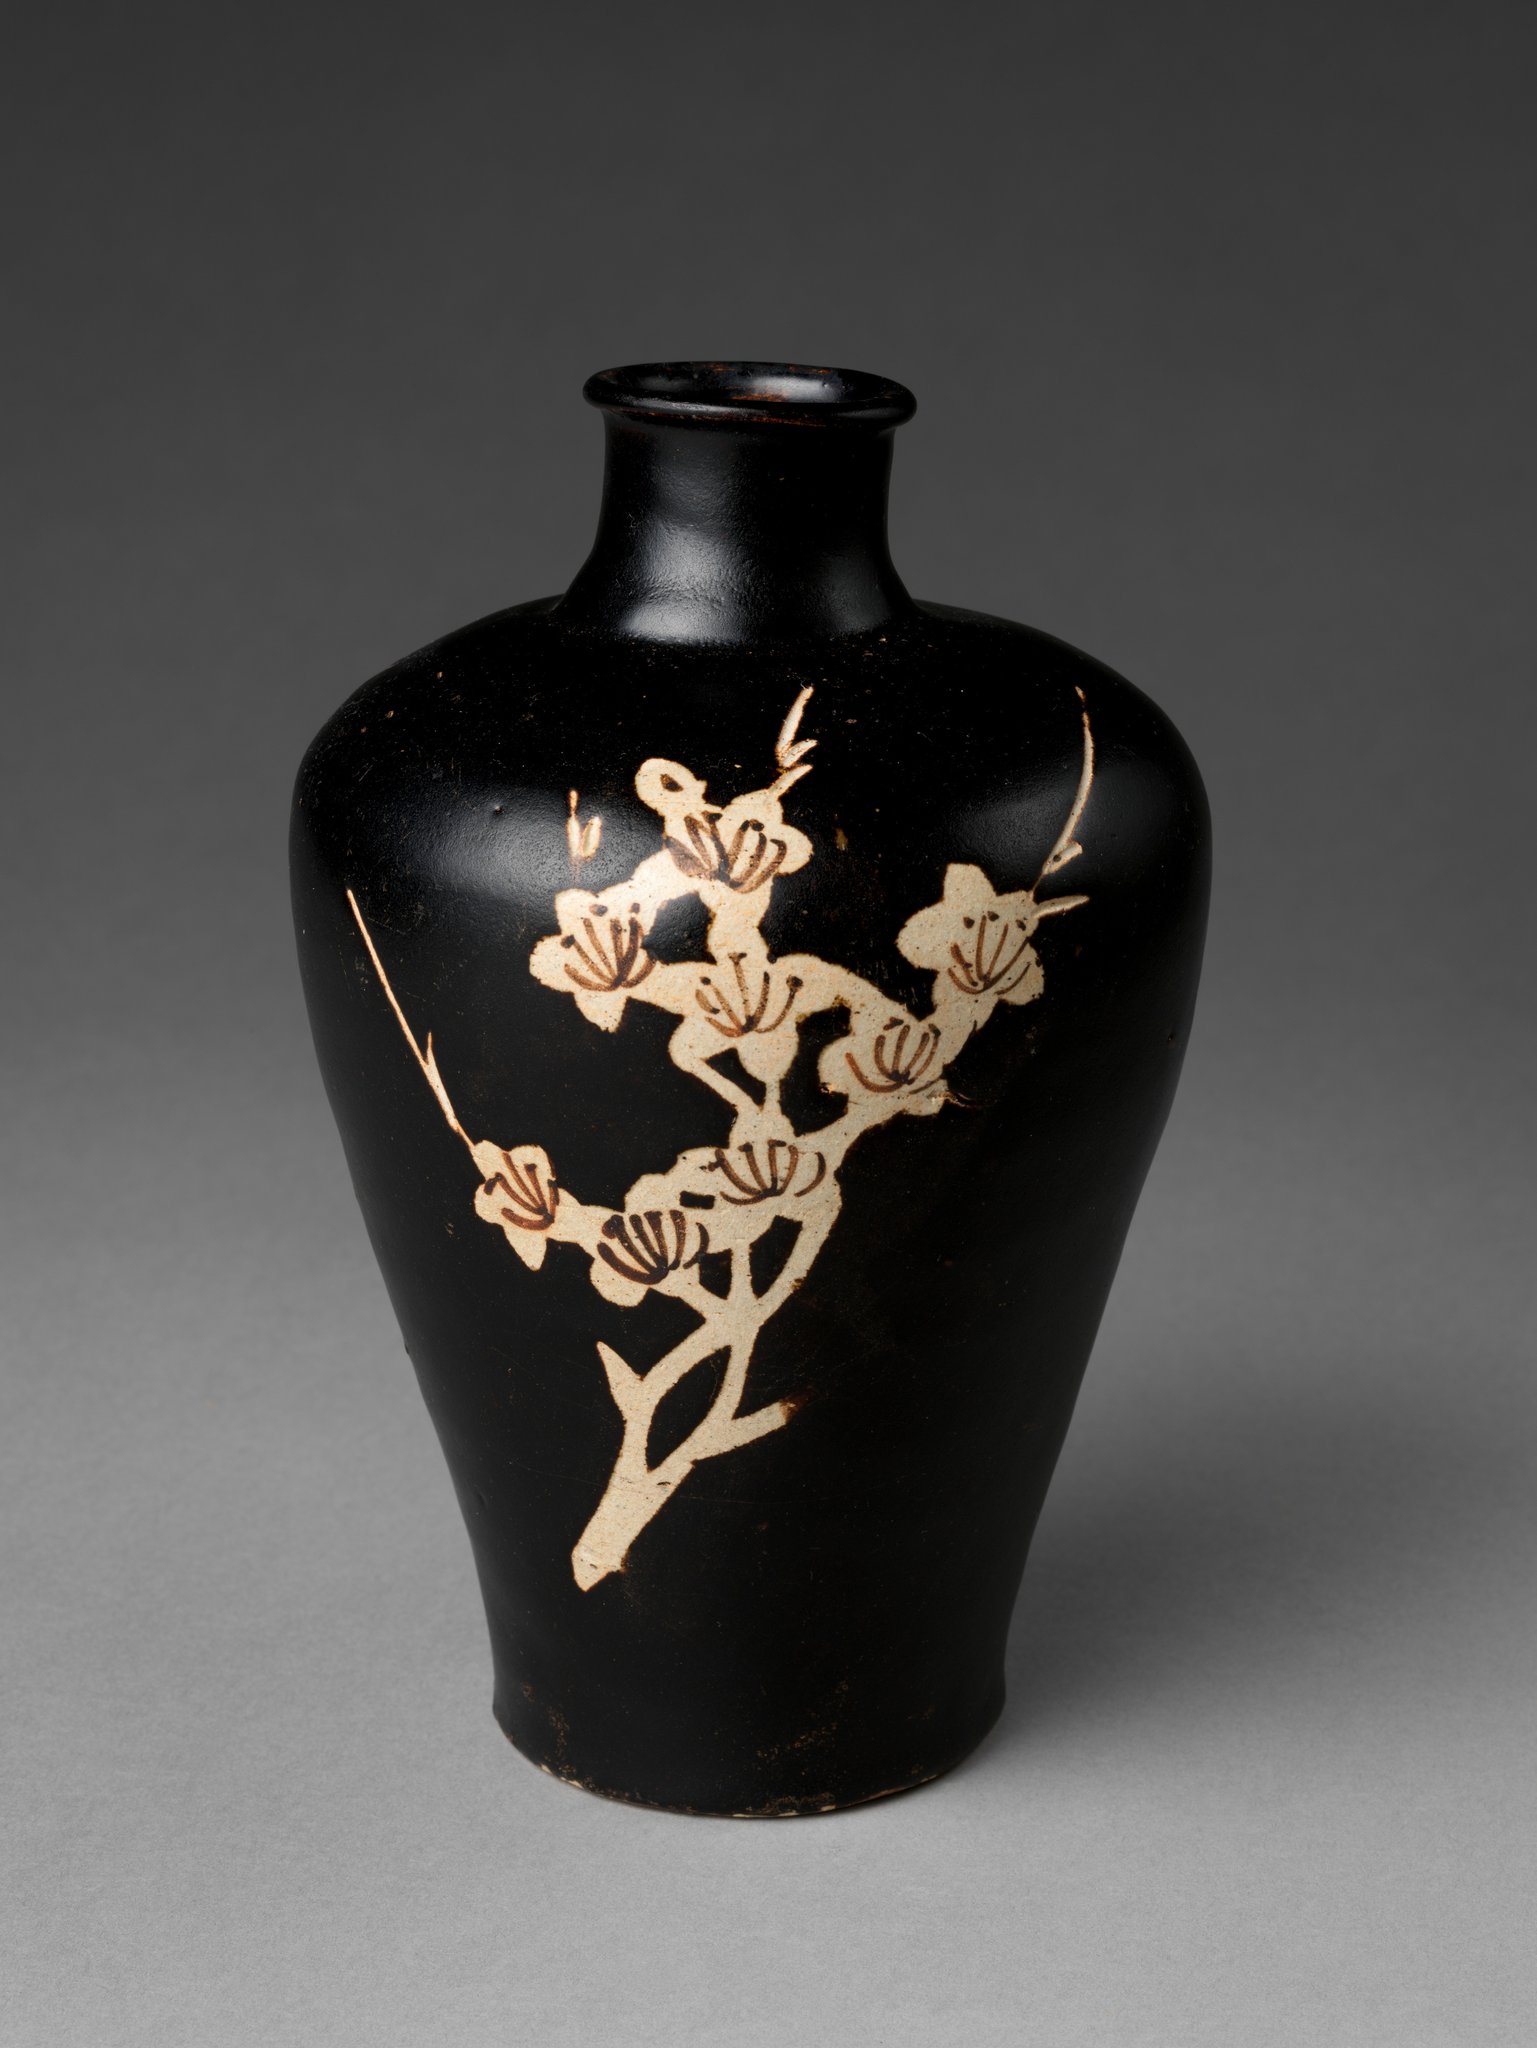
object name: vase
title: Vase with Flowering Plum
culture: chinese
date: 1201-1400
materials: glaze, stoneware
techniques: carving, painting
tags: flowers,trees